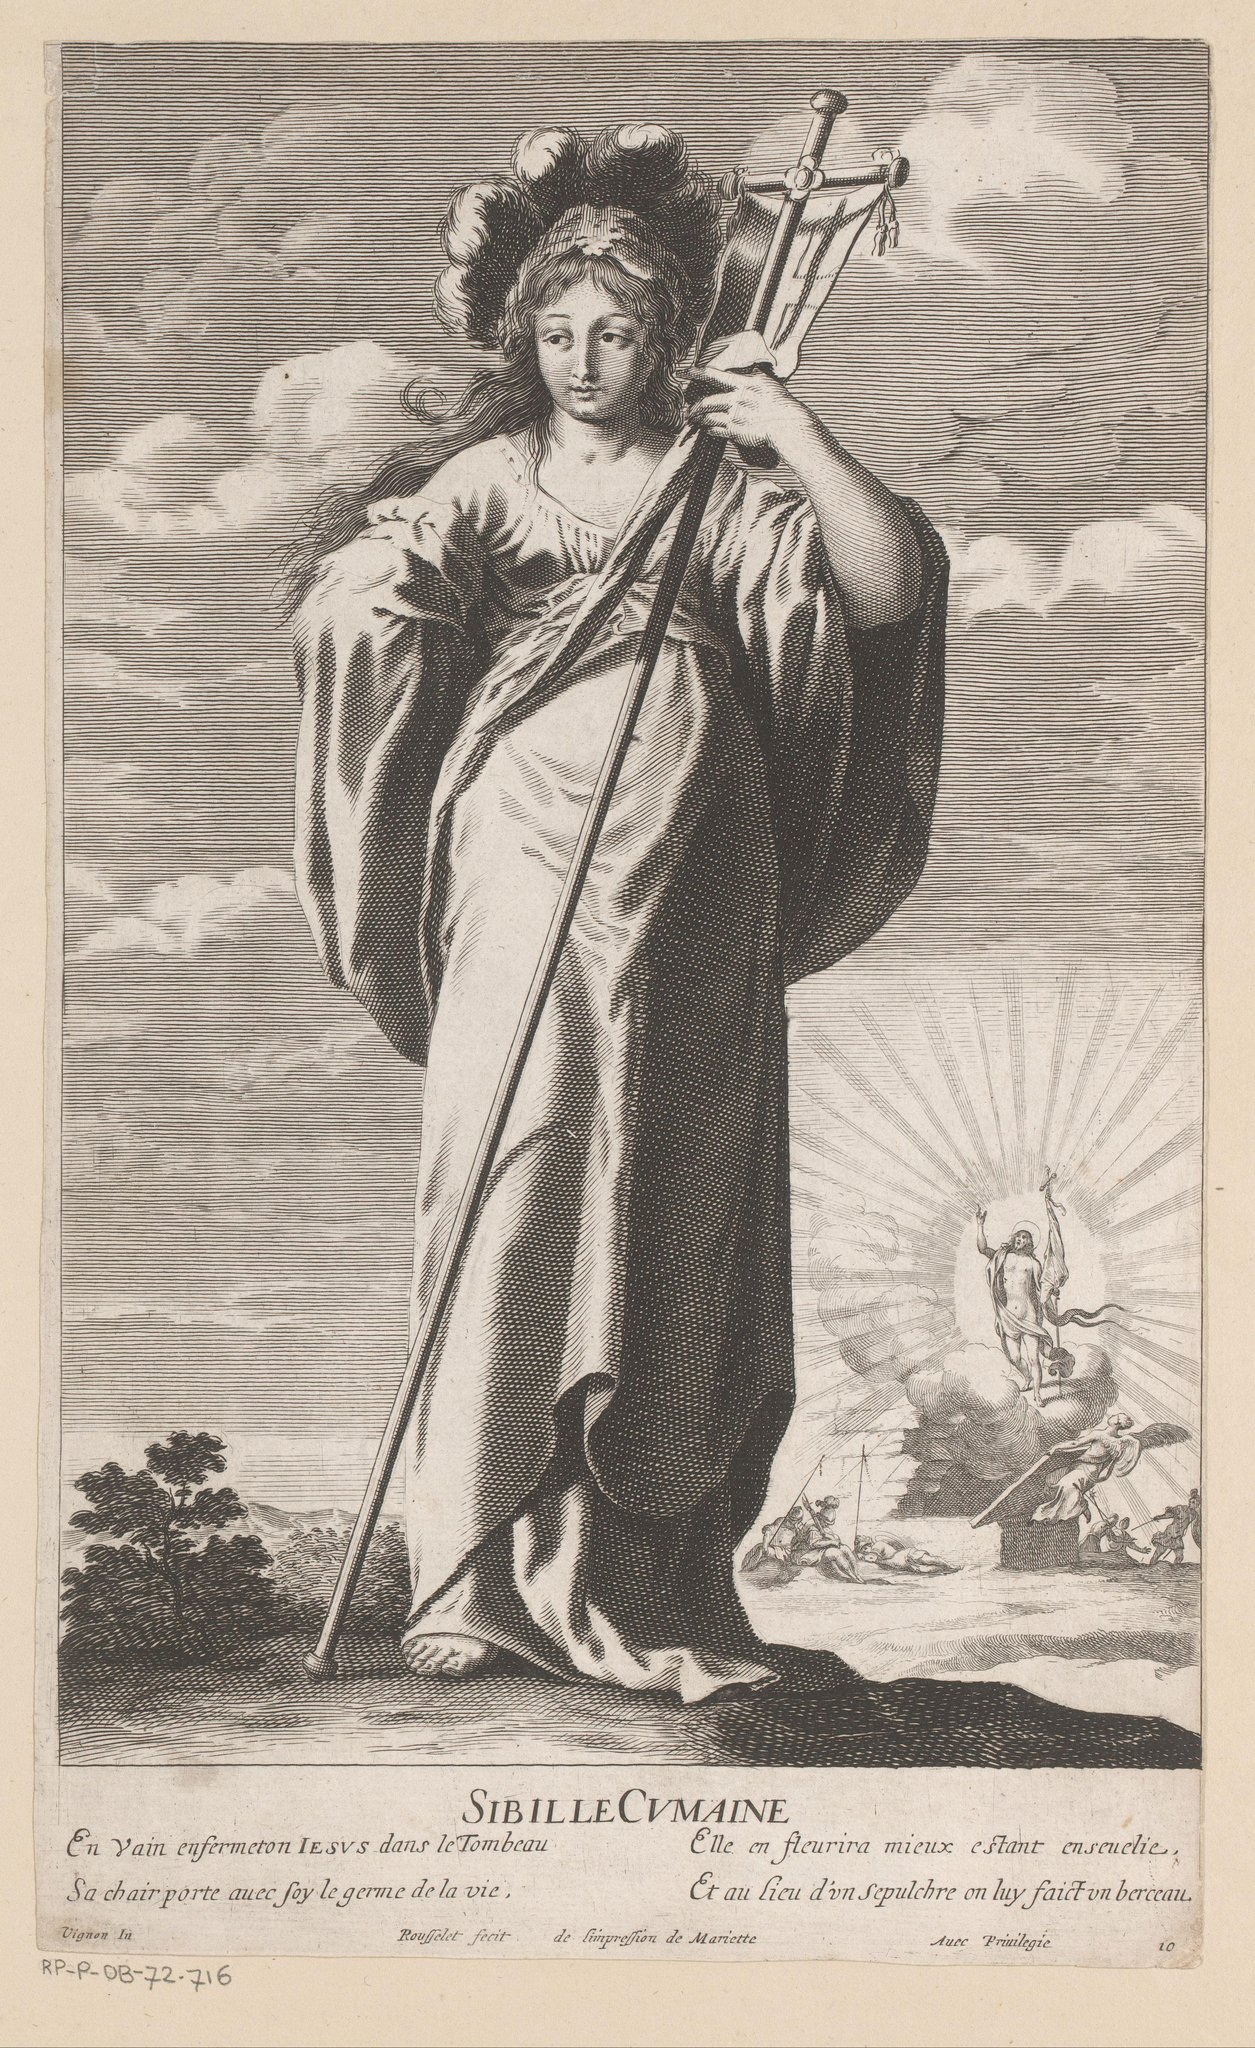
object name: print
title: Sibille Cumaine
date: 1635-1640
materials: paper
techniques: engraving, etching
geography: france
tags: christ standing on or near the tomb ~ events after the resurrection, cumaean sibyl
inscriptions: collector's mark: Lugt 240